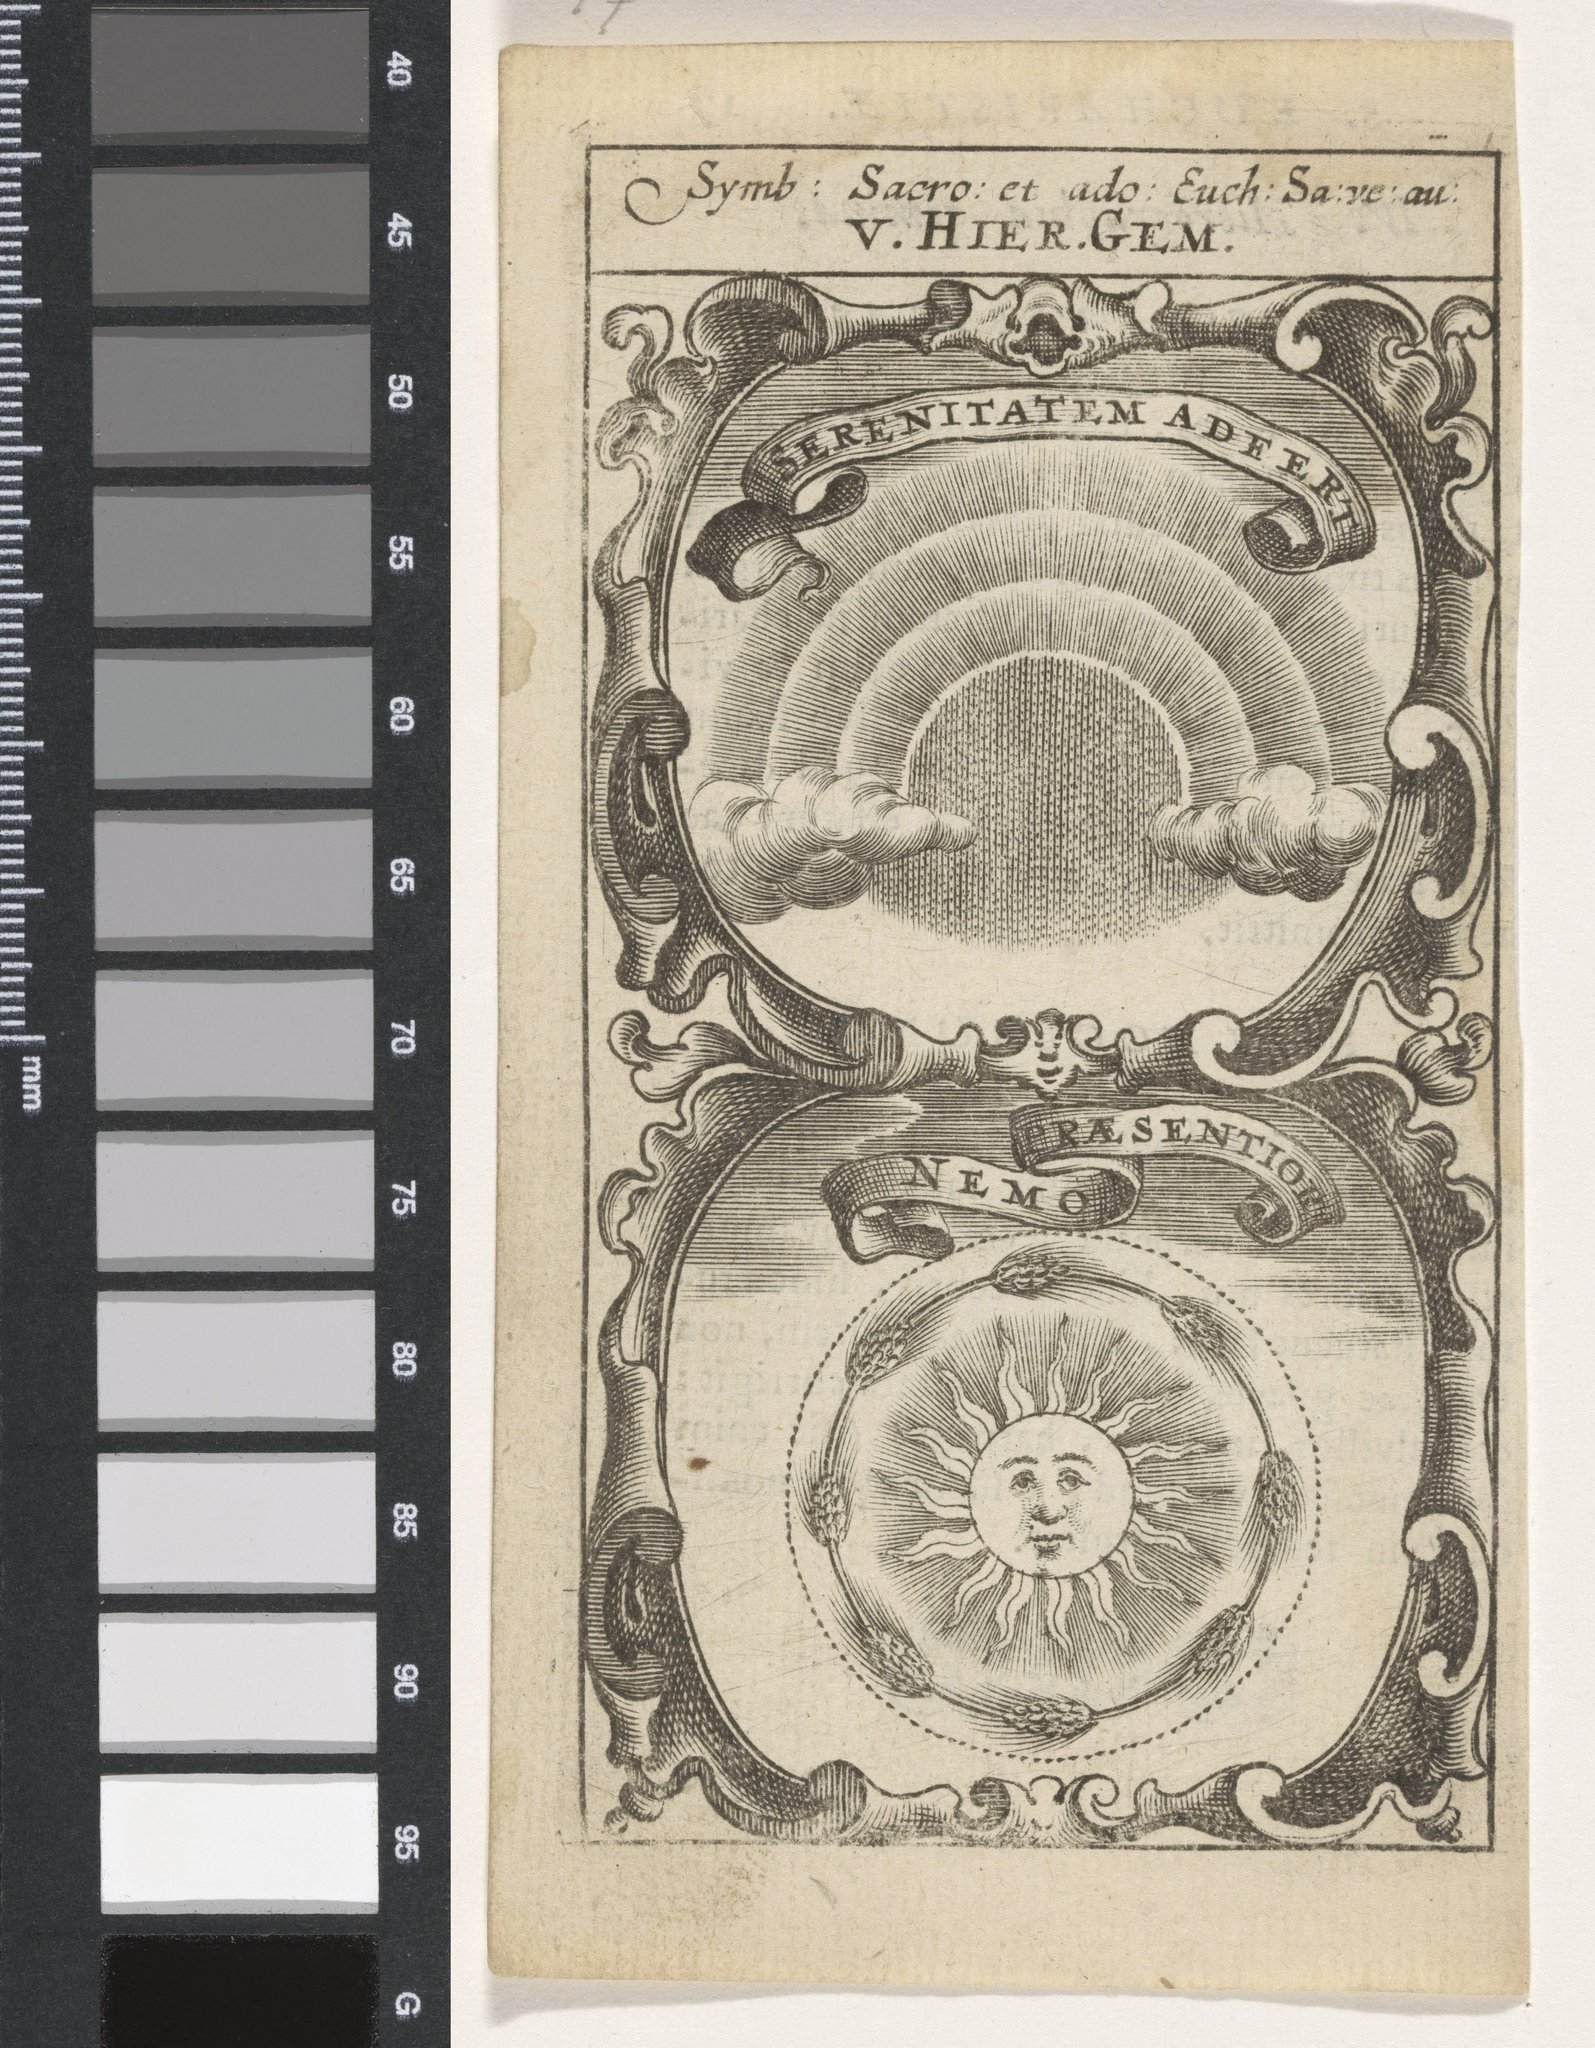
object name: book illustration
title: Regenboog / Zon omringt door korenaren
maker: Anonymous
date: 1666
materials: paper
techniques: engraving, letterpress printing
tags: sun represented as face, wheel, etc., ear of corn, rainbow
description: Pagina uit Jacob Typotius, Symbola Divina & Humana Pontificum Imperatorum Regum. Arnhem, J.F. Hagen, 1666 of uit de titeluitgave van 1669 of 1679. Het werk van Typotius werd voor het eerst uitgegeven in 1601 met prenten van Aegidius Sadeler.